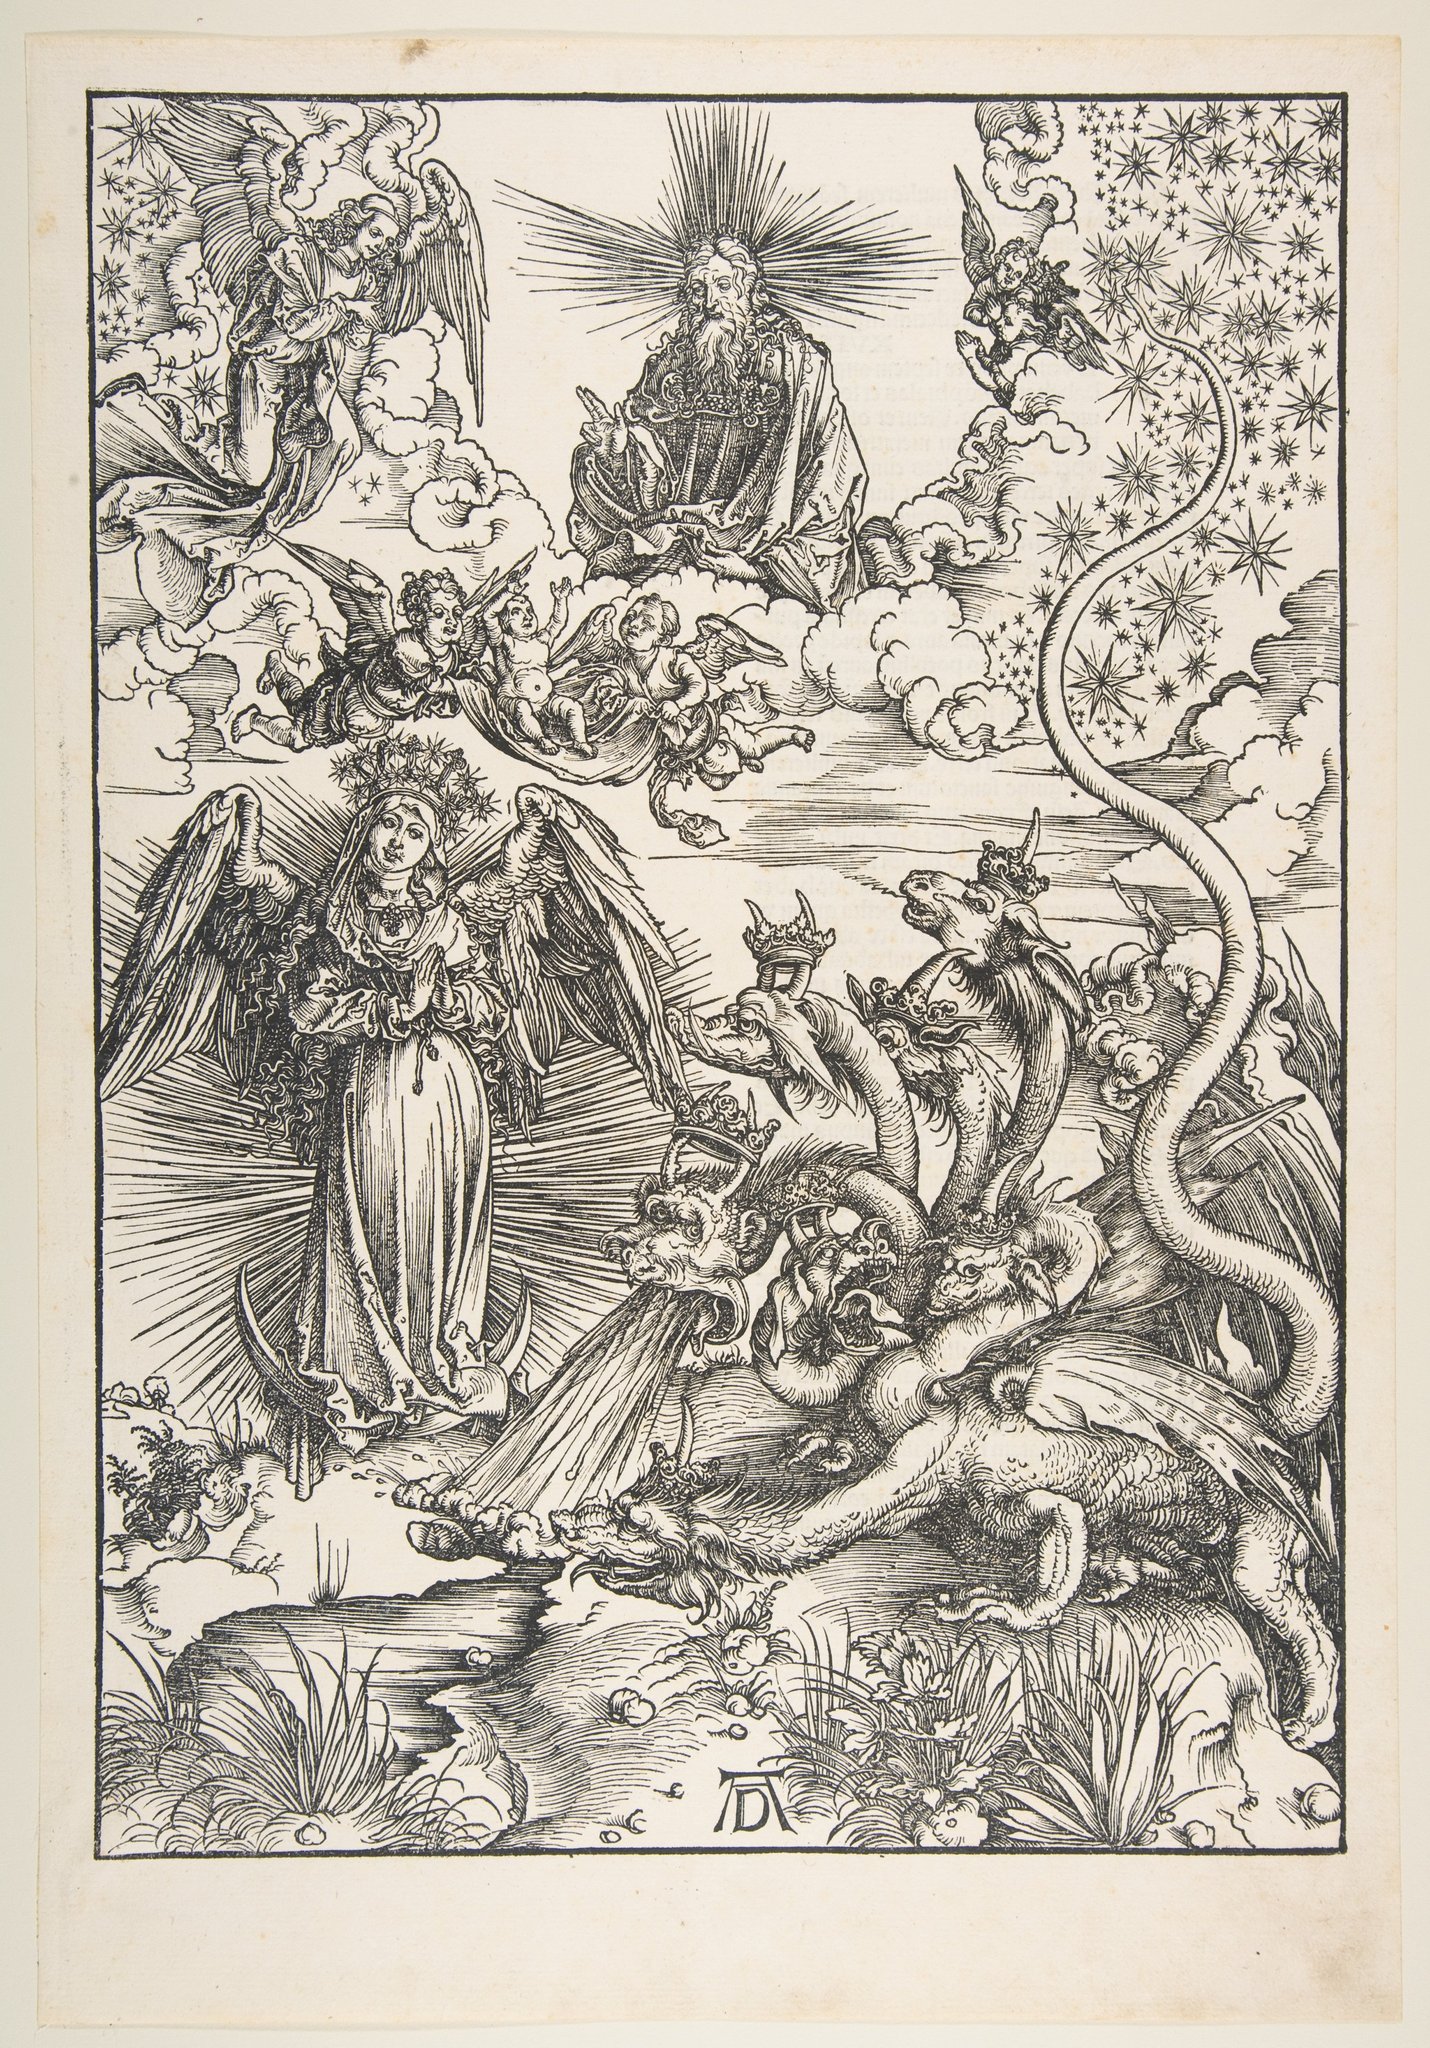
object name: print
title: The Apocalyptic Woman, from "The Apocalypse"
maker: albrecht dürer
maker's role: artist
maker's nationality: german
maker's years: 1471-1528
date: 1511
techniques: woodcut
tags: women,angels,jesus